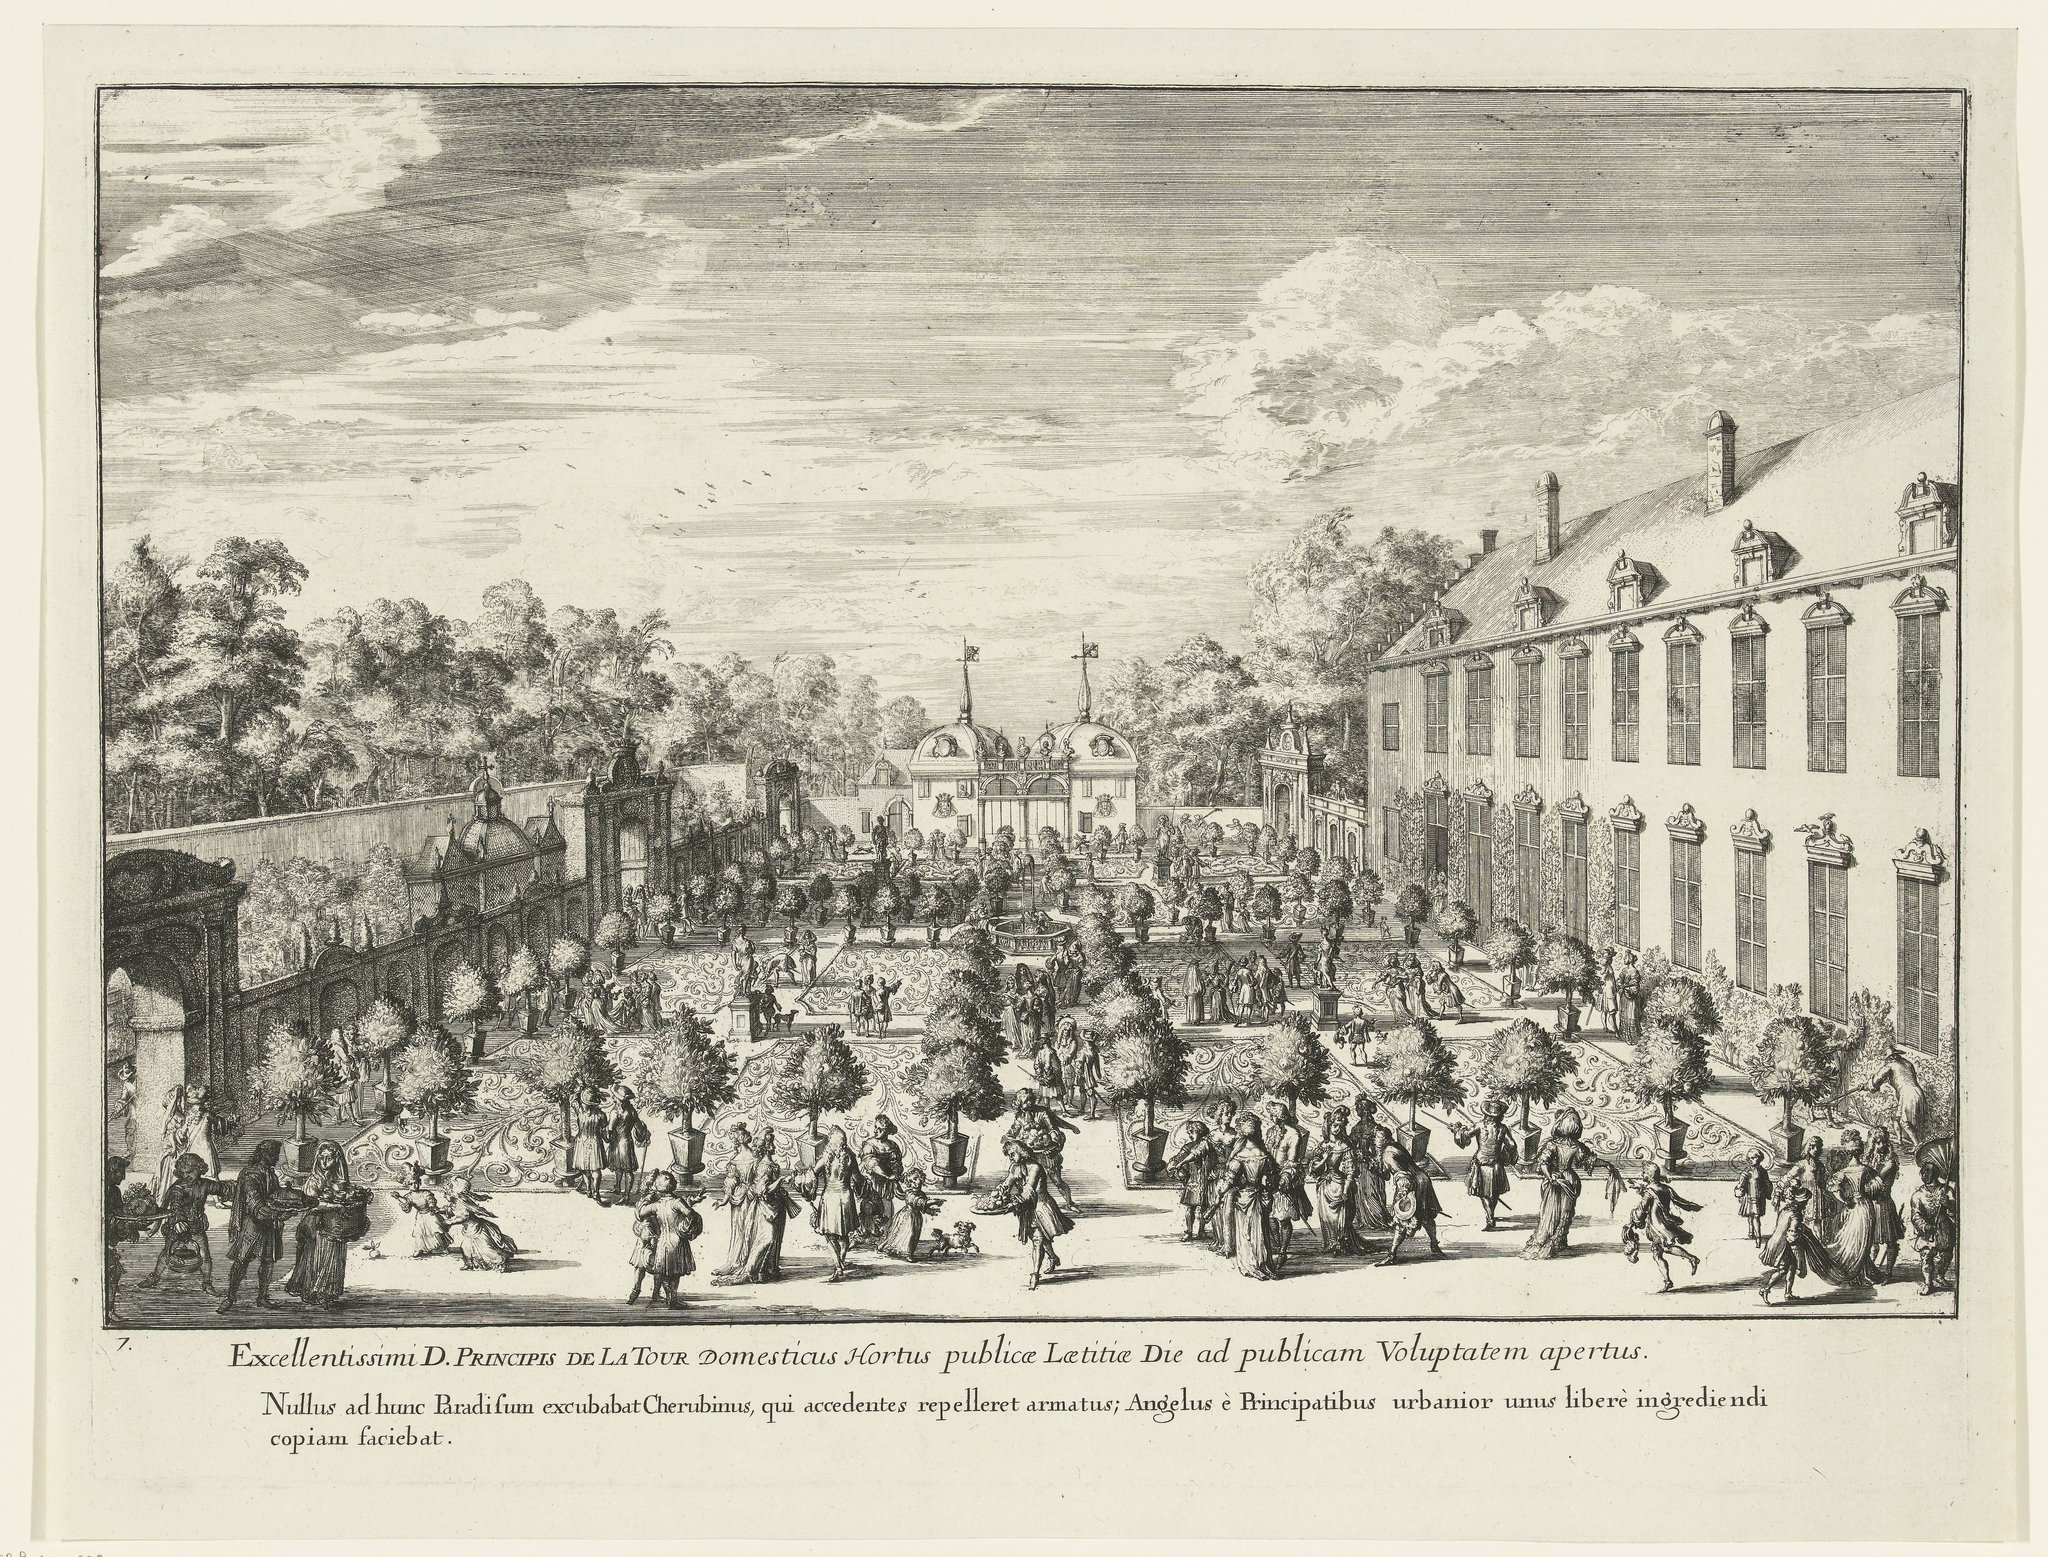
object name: print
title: Bezoekers van de tuinen van het Hof van Thurn en Tassis in Brussel, 1686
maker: romeyn de hooghe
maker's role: draughtsman, goldsmith, painter, print maker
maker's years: 1645-1708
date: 1686-1687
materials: paper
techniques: etching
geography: haarlem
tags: leopold i (keizer van duitsland), park, garden, brussels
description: Bezoekers van de tuinen van het Hof van Thurn en Tassis in Brussel. Op de voorgrond lopen bedienden met schalen met eten.